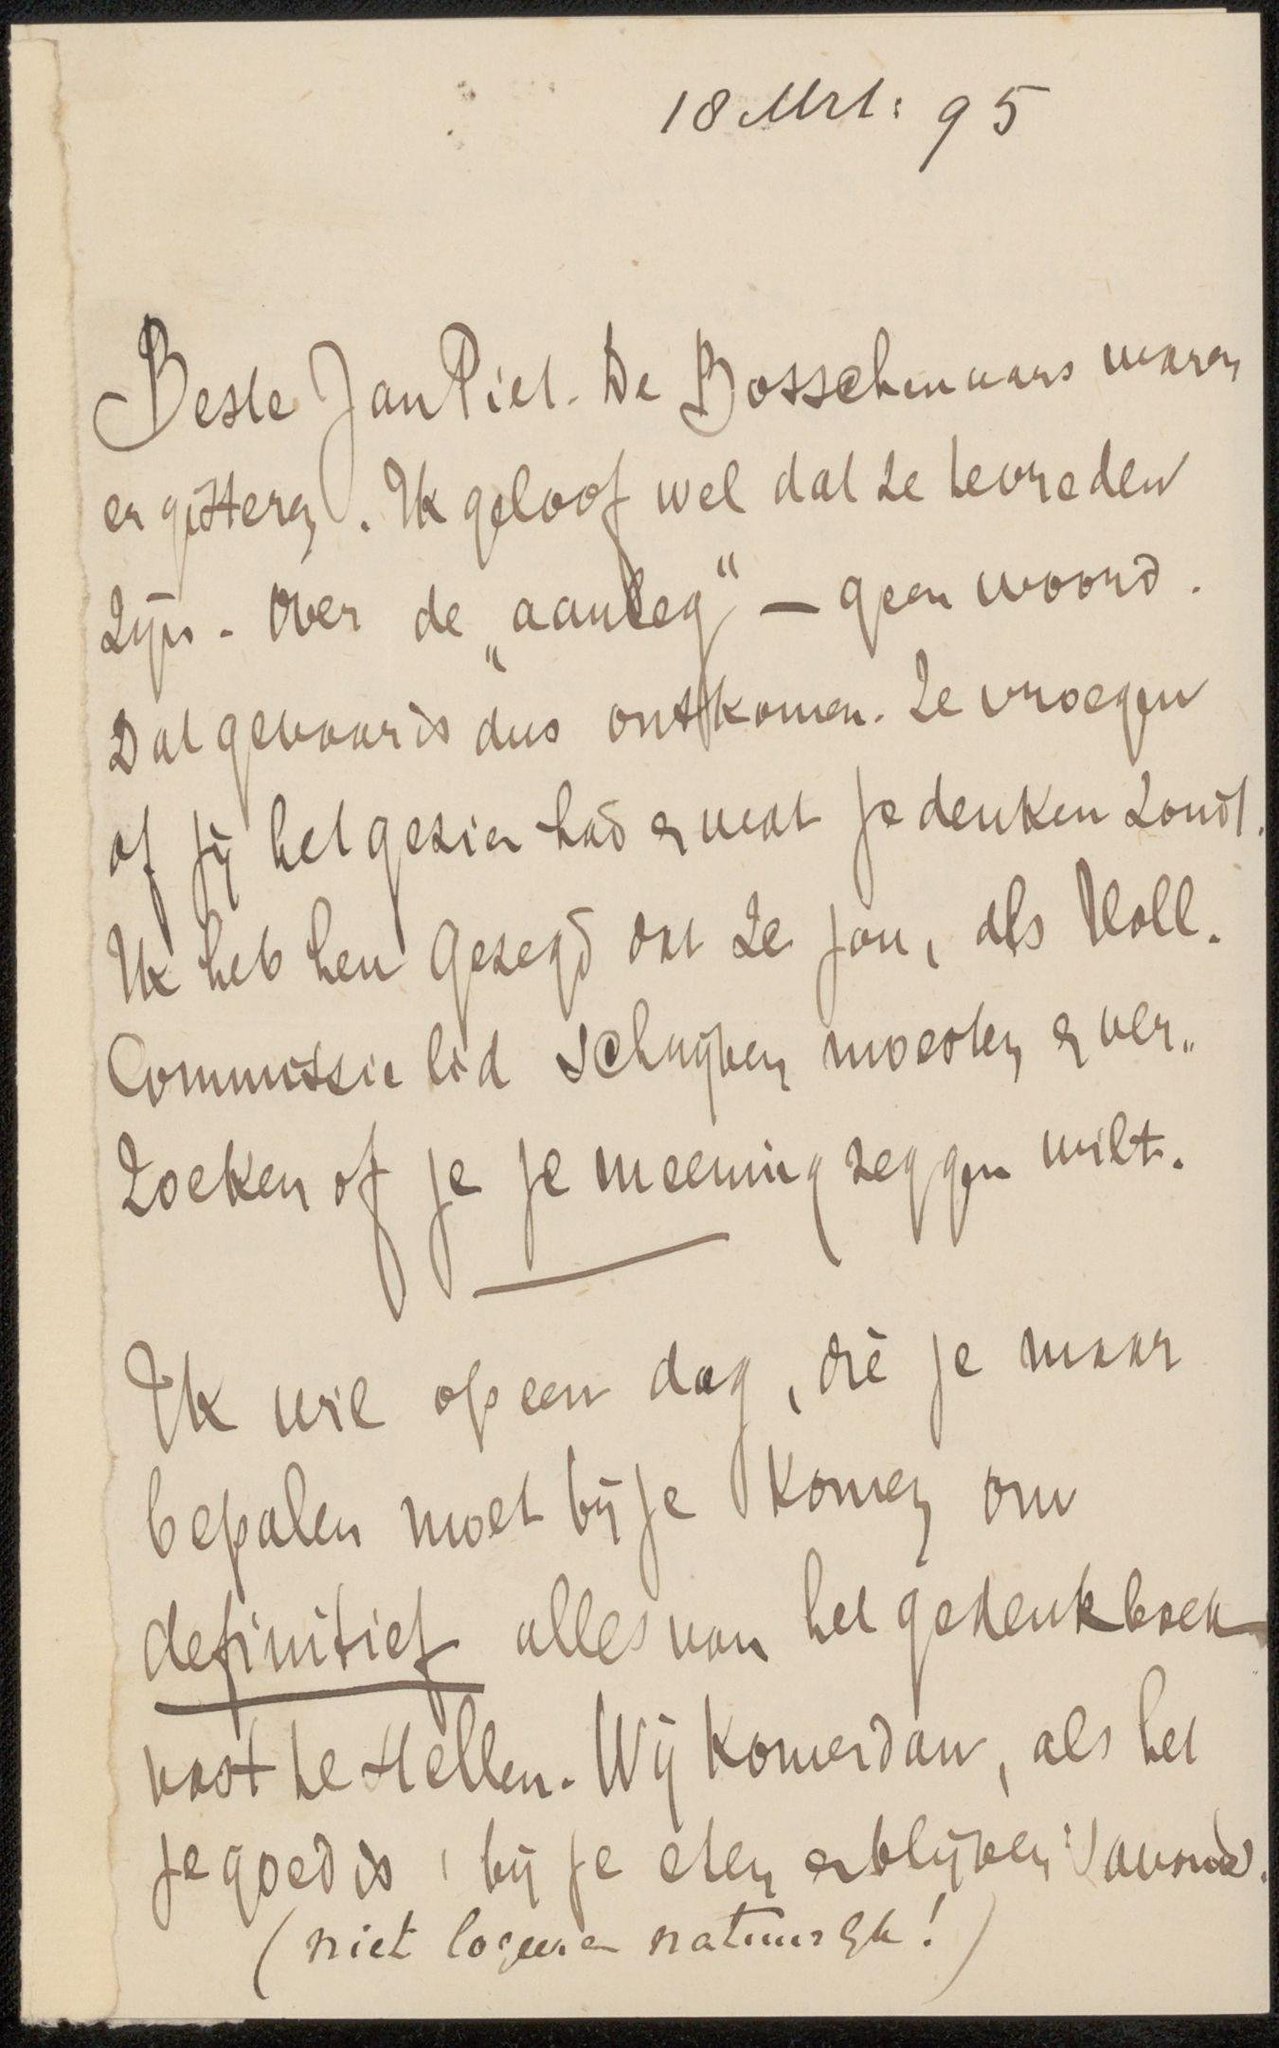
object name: letter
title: Brief aan Jan Veth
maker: antoon derkinderen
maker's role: draughtsman, painter, print maker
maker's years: 1859-1925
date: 1874-1925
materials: ink, paper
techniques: pen, writing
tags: dordrecht, amsterdam, painter, print maker, draughtsman, designer, jan veth, printed matter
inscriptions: collector's mark: ‘RPK’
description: Brief gedateerd 18 Mrt: 95 in latere hand.